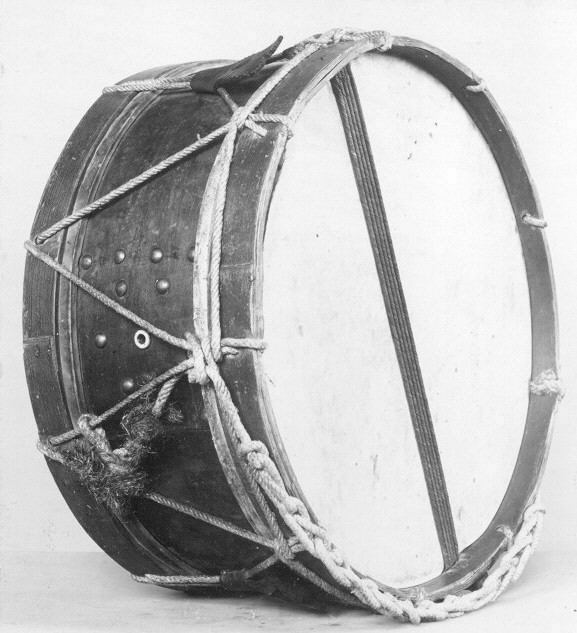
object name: snare drum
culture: american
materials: fiber, skin, wood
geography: united states